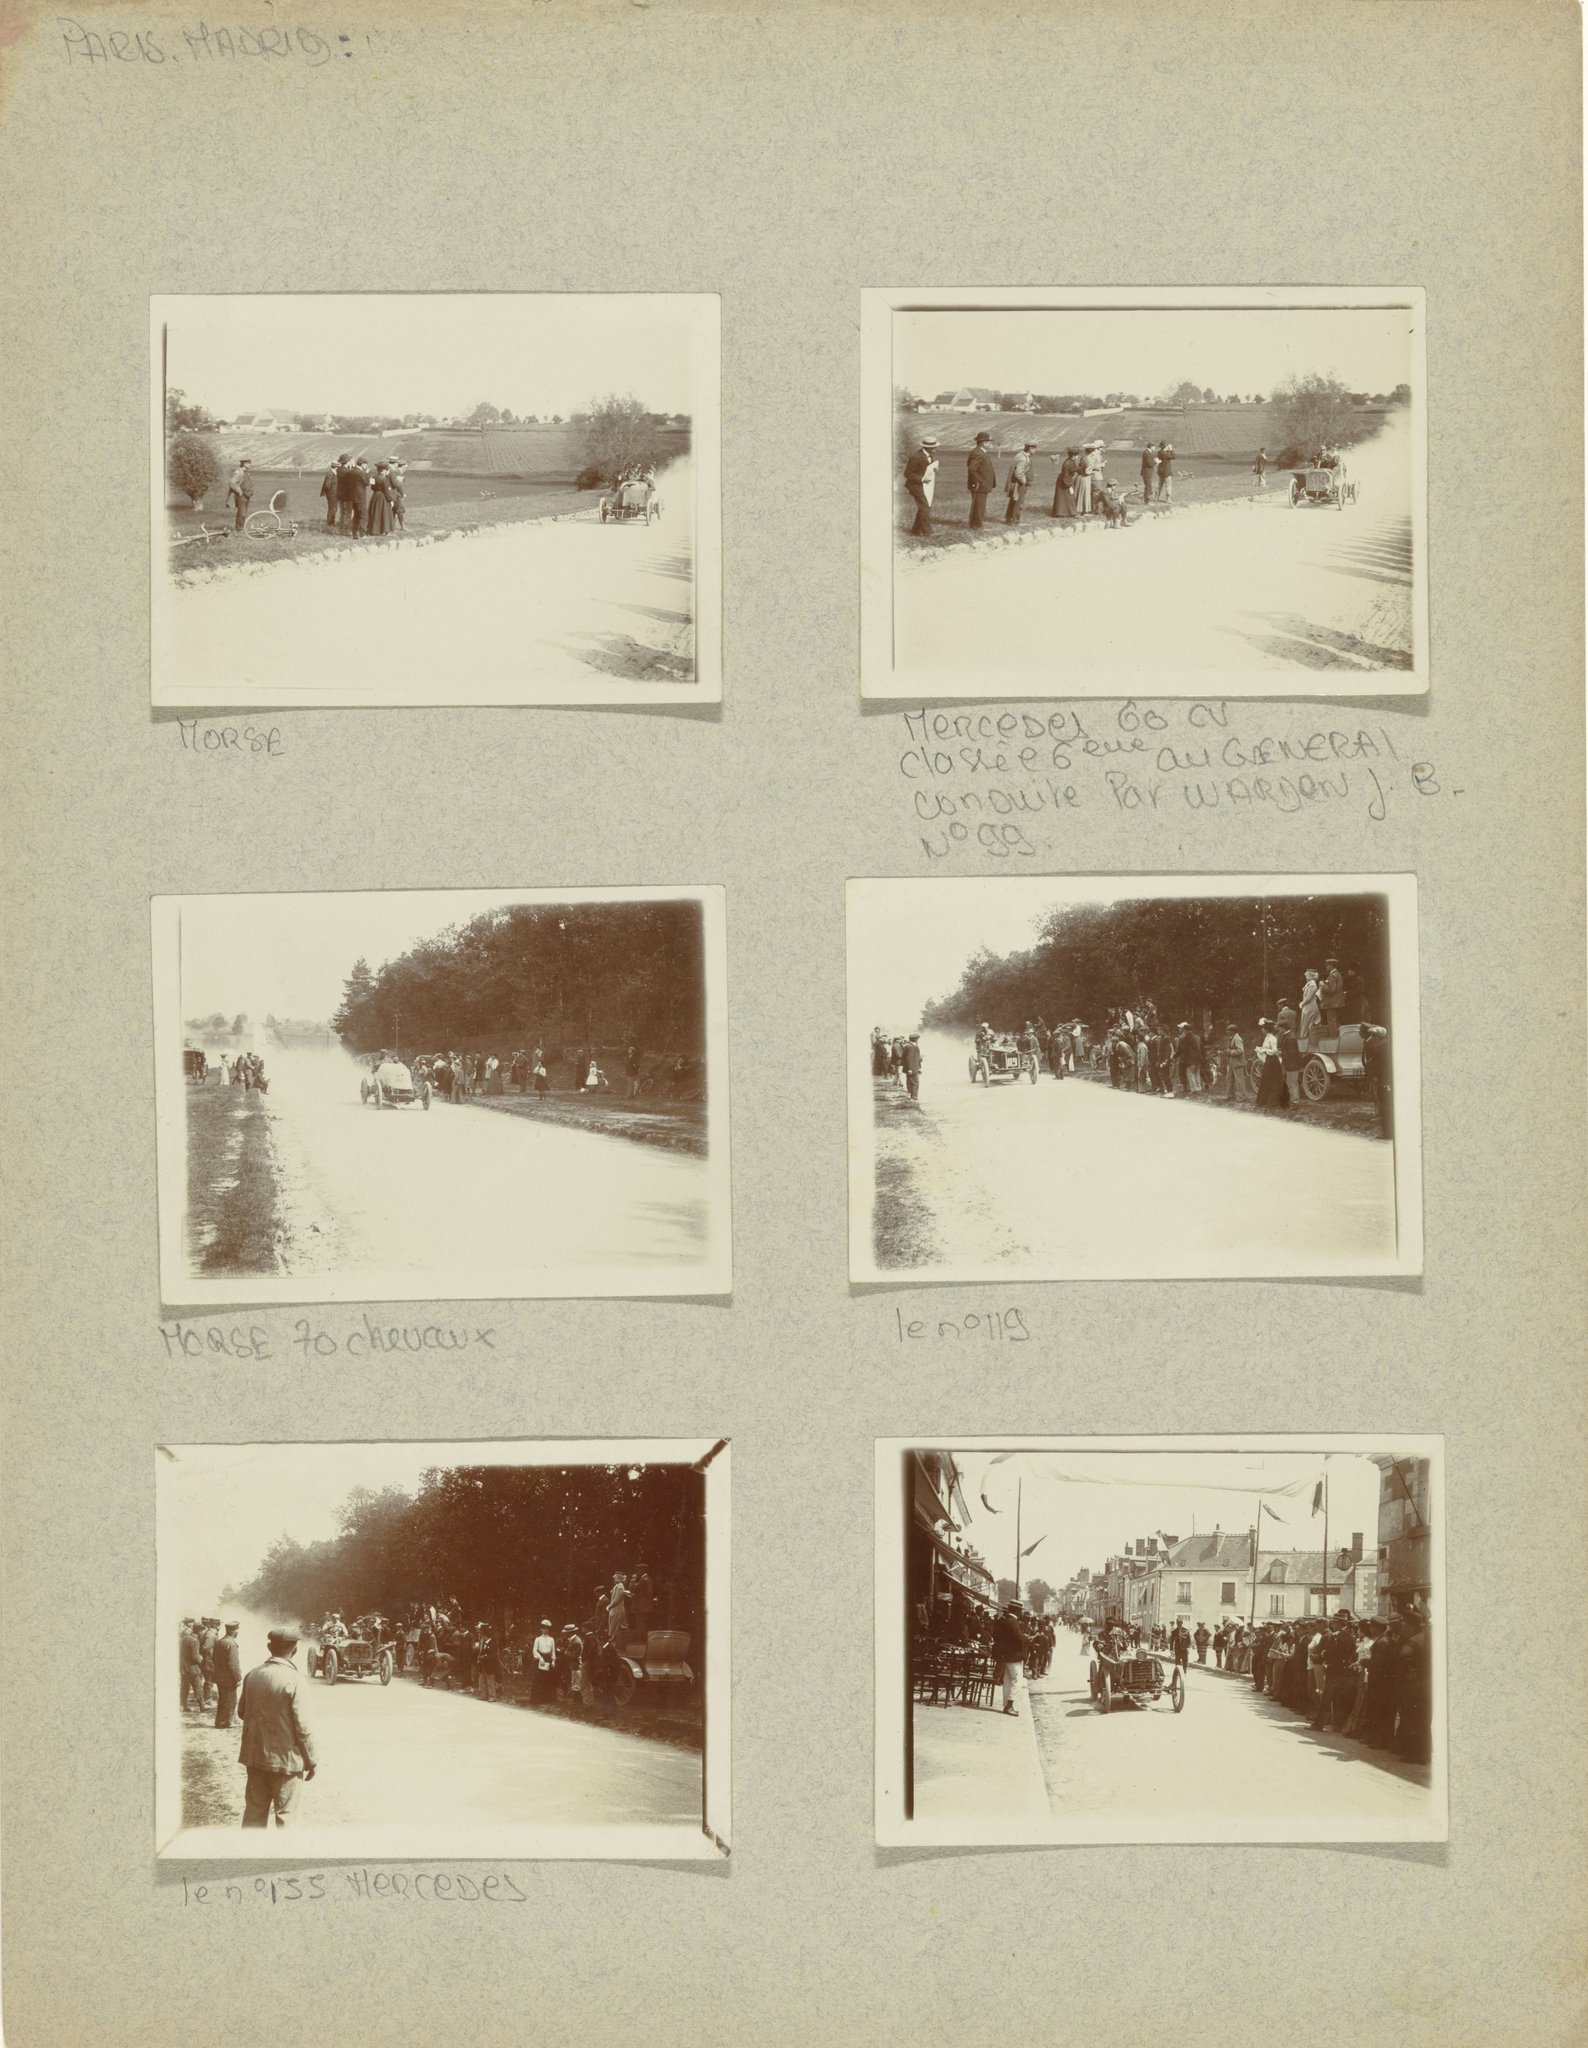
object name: album leaf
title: Albumblad met zes foto’s van de autorace tussen Parijs en Madrid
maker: Anonymous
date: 1903-1905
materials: paper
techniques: gelatin silver print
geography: france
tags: motorcar racing, france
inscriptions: inscription: ‘Paris-Madrid (...) Mercedes’